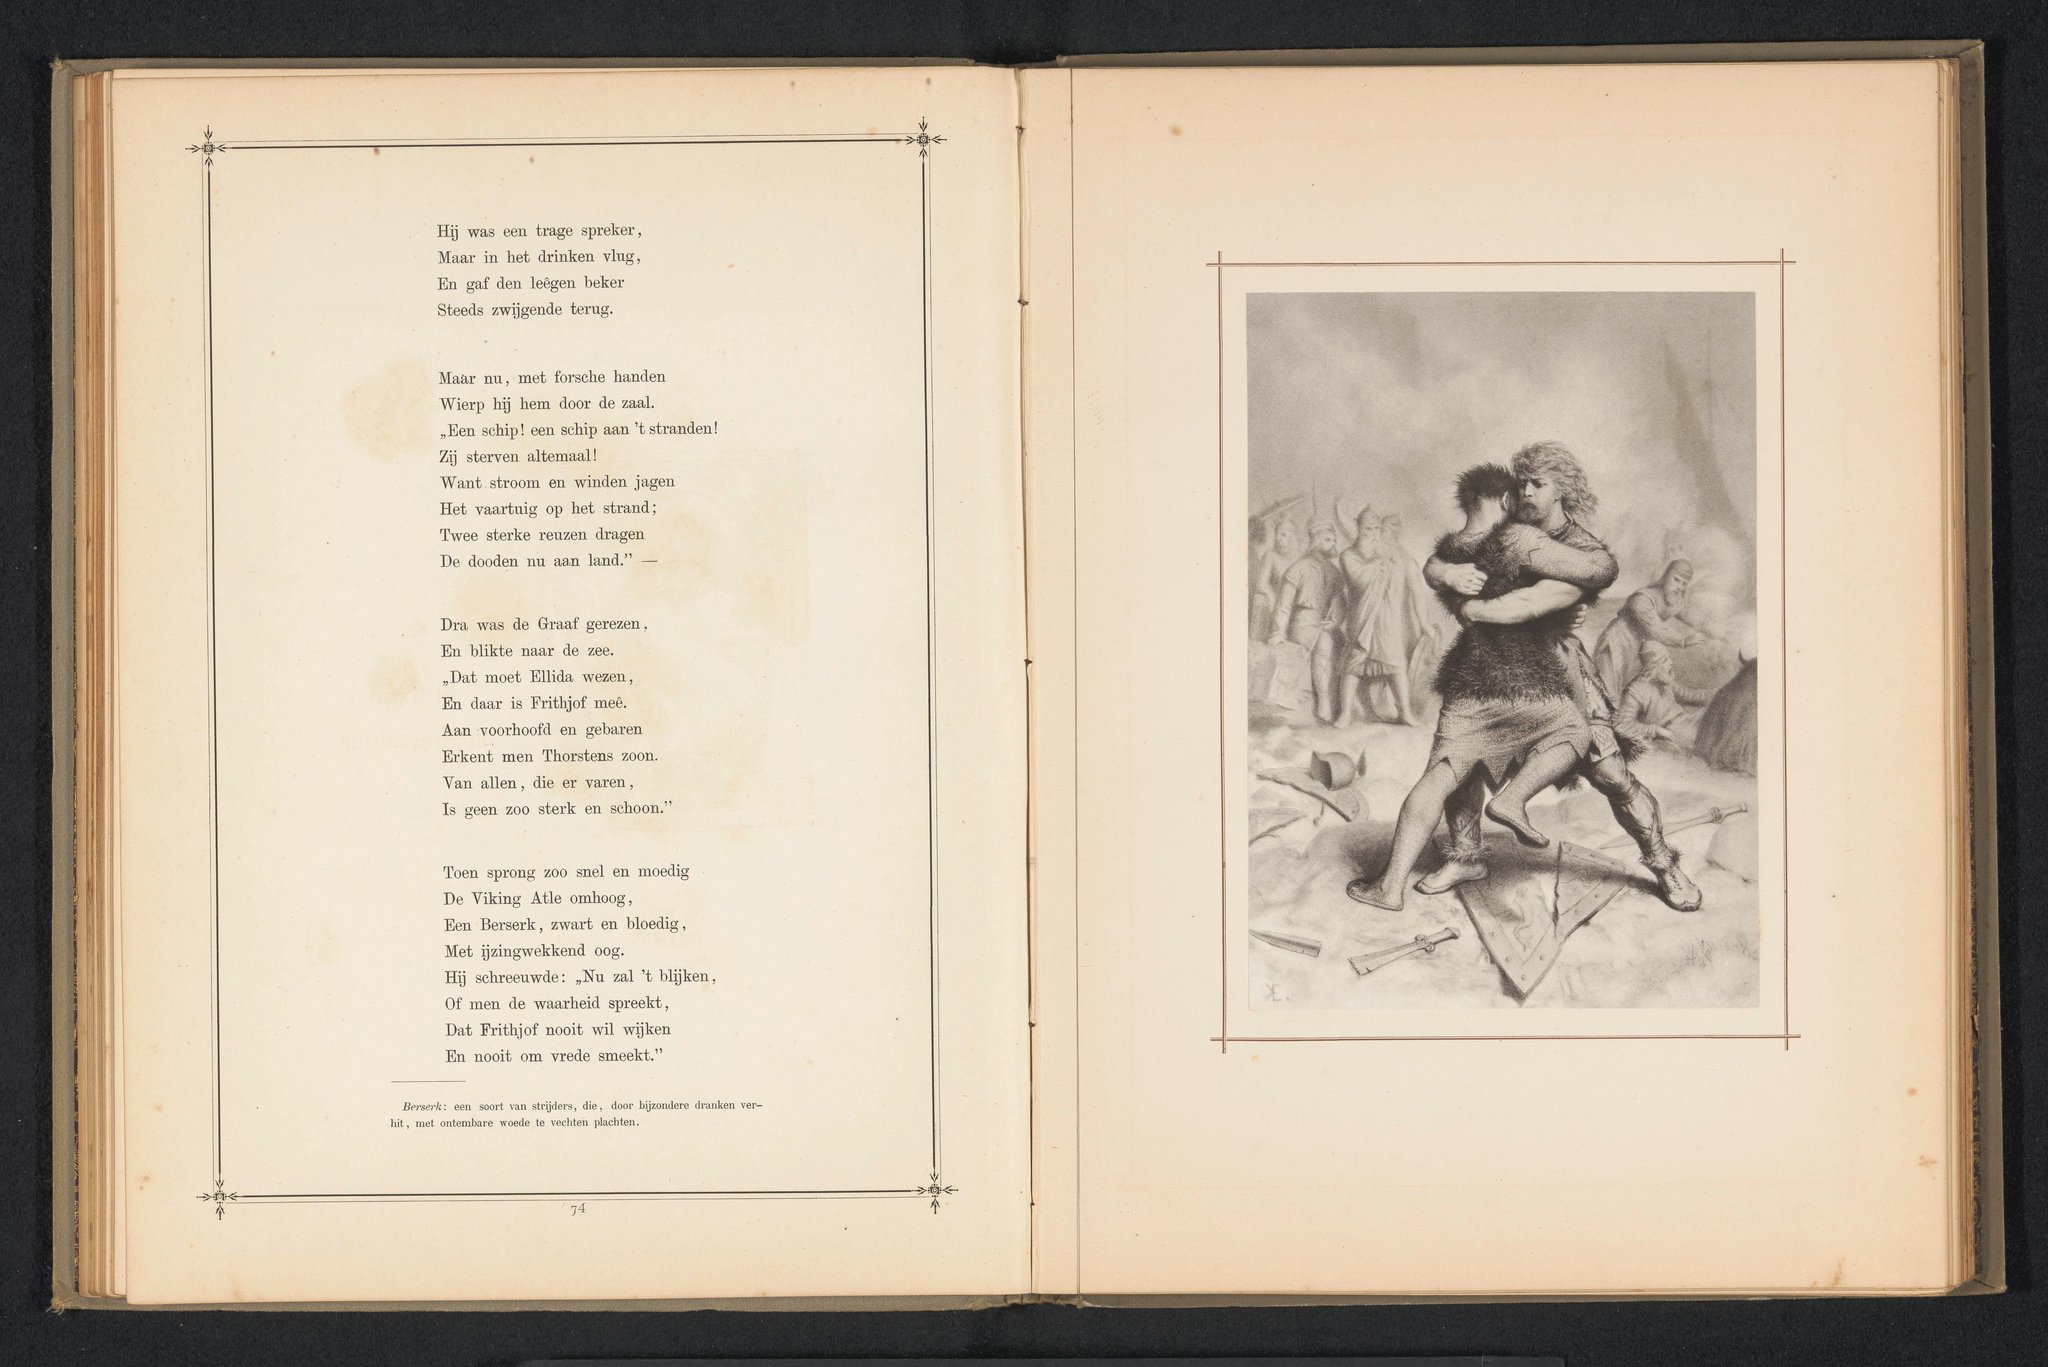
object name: page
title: Fotoreproductie van een tekening van twee vechtende mannen, vermoedelijk Frithjof en Angantuur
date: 1872-1882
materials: paper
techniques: photograph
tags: fighting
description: Scene uit de Frithiof's Saga door Esaias Tegnér.